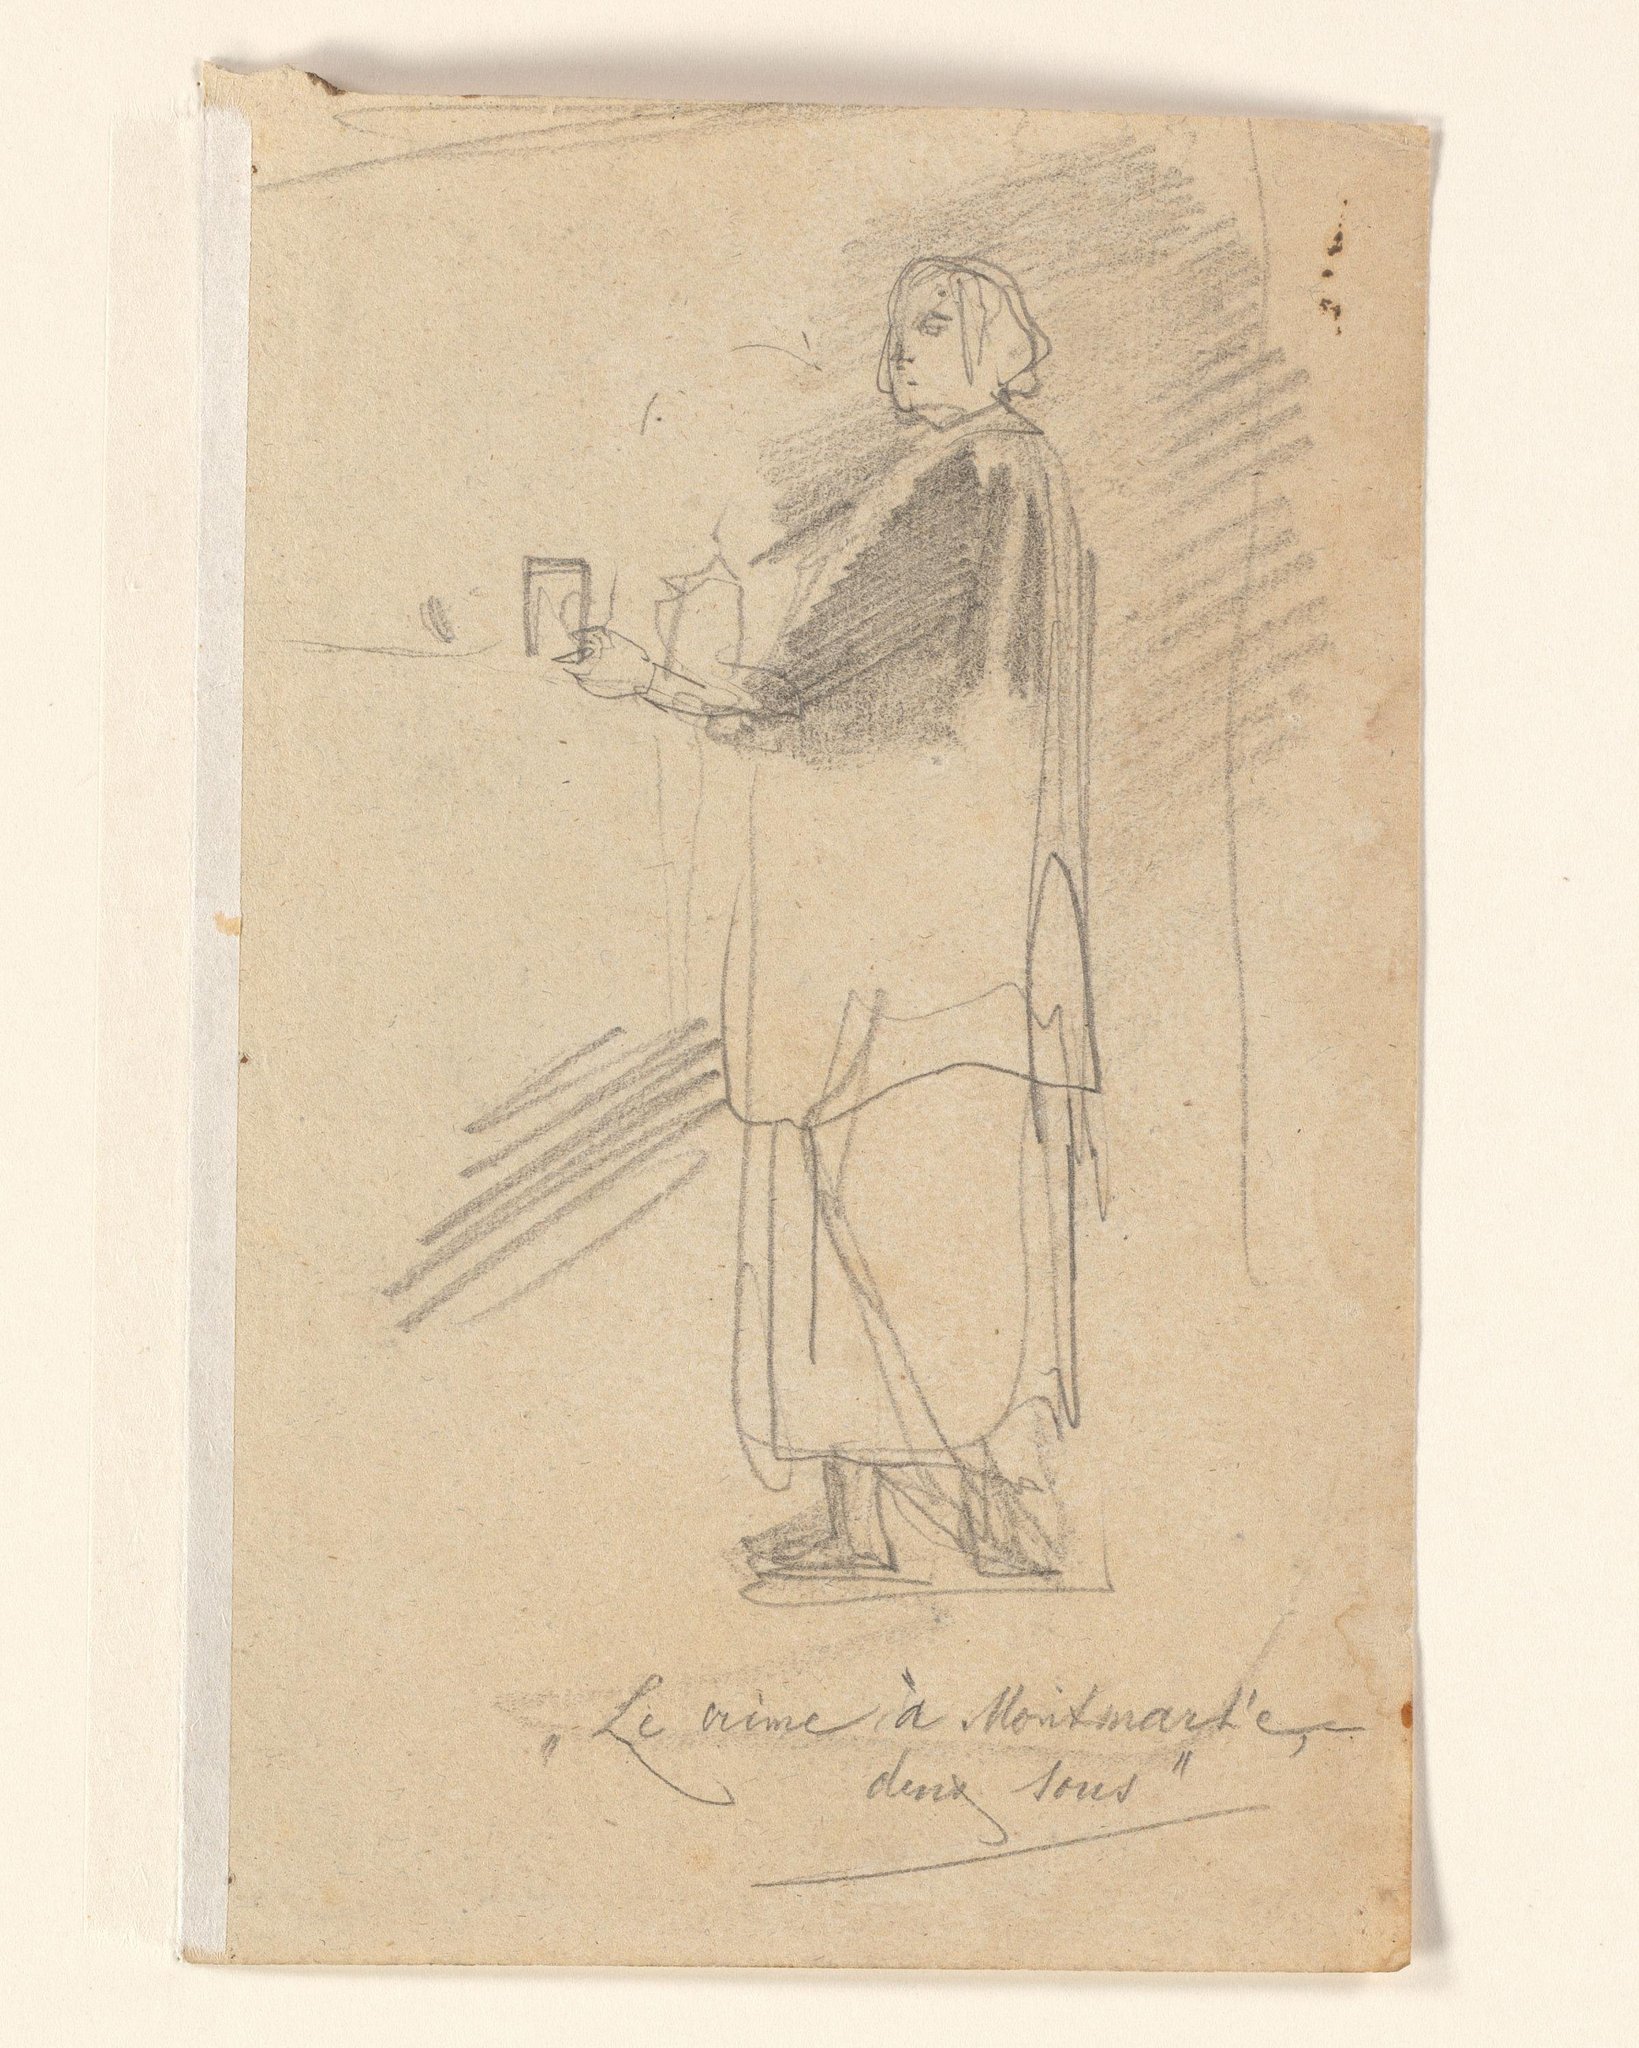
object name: drawing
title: Schetsblad Le crime à Monmartr (...)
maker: august allebé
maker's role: draughtsman, print maker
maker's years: 1838-1927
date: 1848-1927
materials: paper, pencil